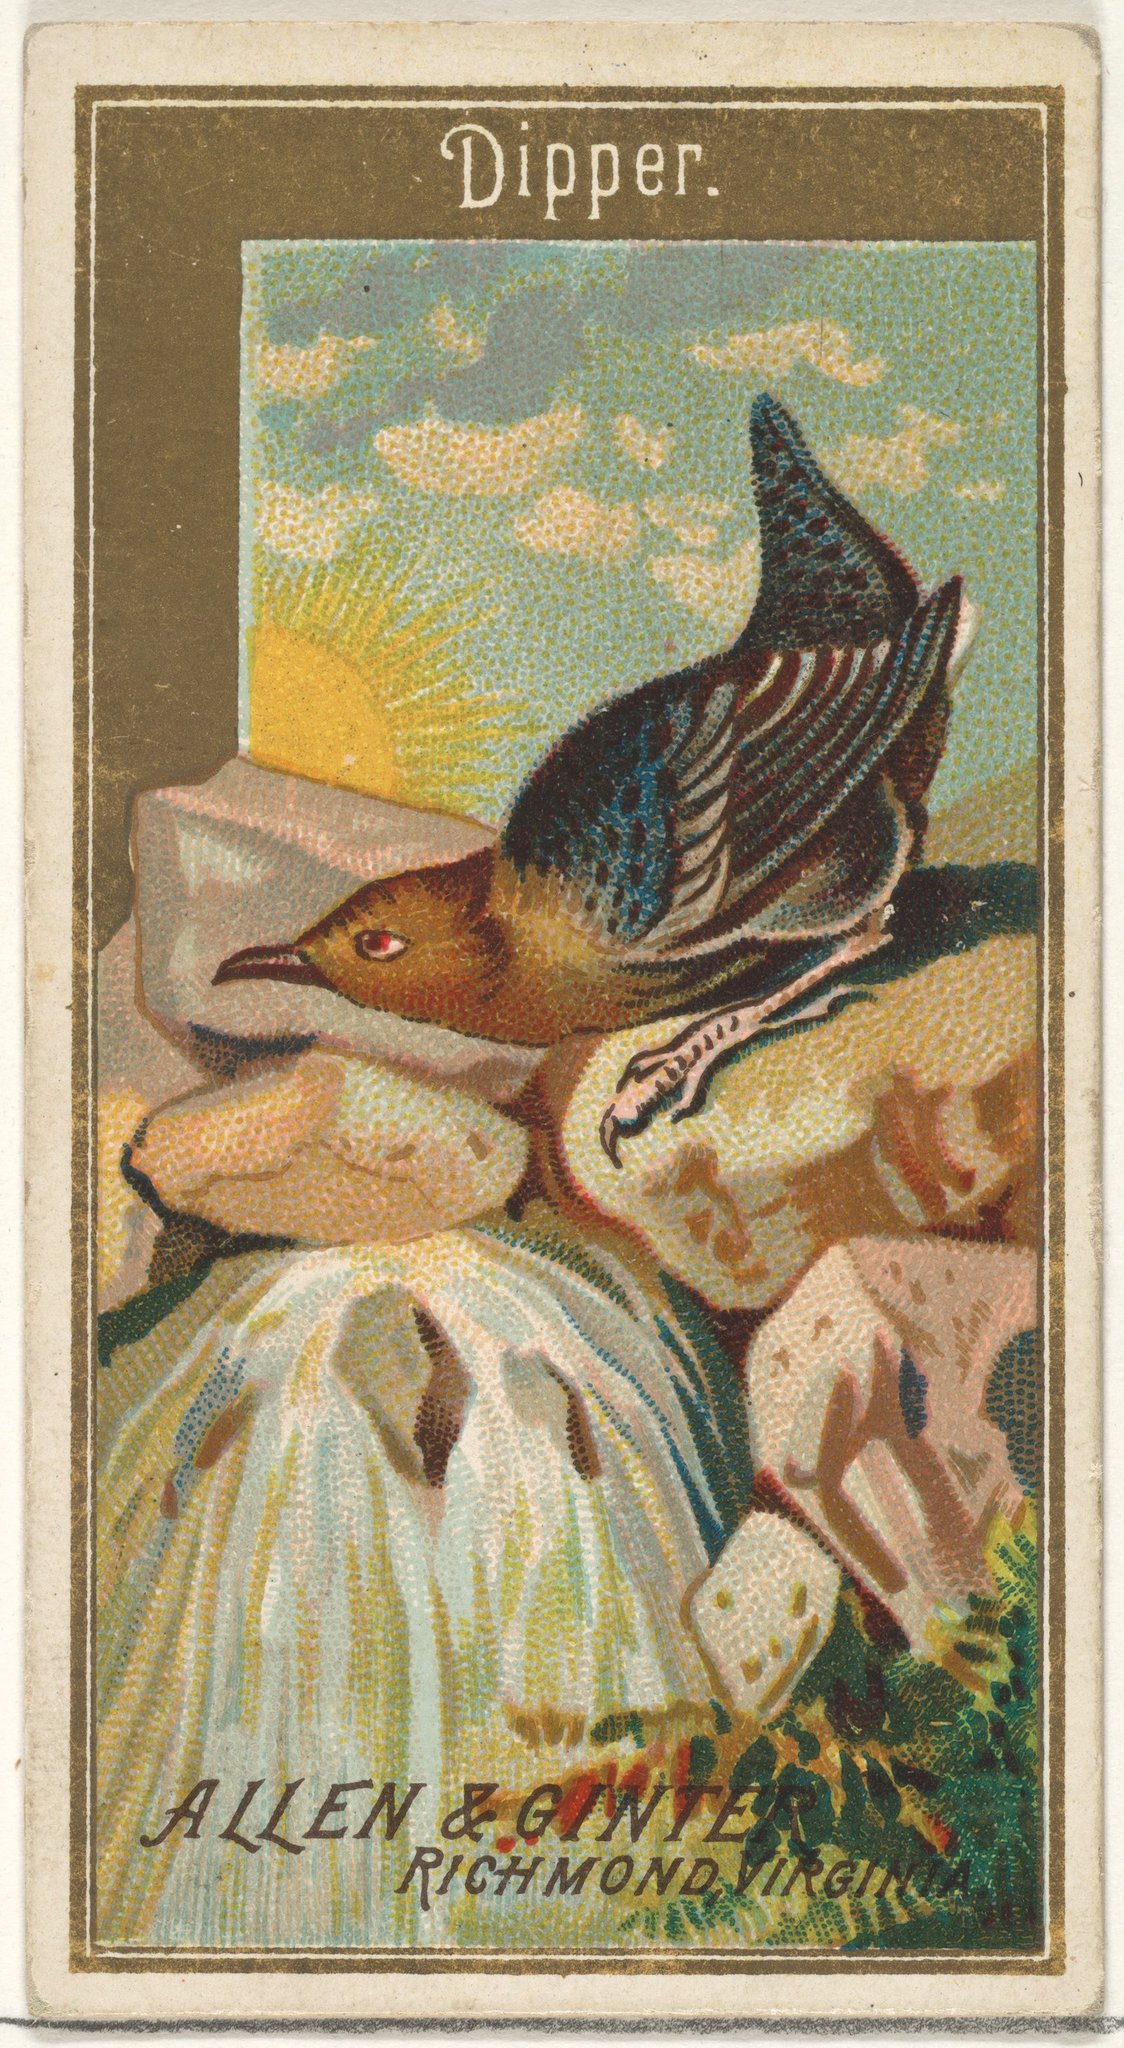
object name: print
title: Dipper, from the Birds of America series (N4) for Allen & Ginter Cigarettes Brands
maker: allen & ginter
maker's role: publisher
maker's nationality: american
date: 1888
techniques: color lithograph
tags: birds